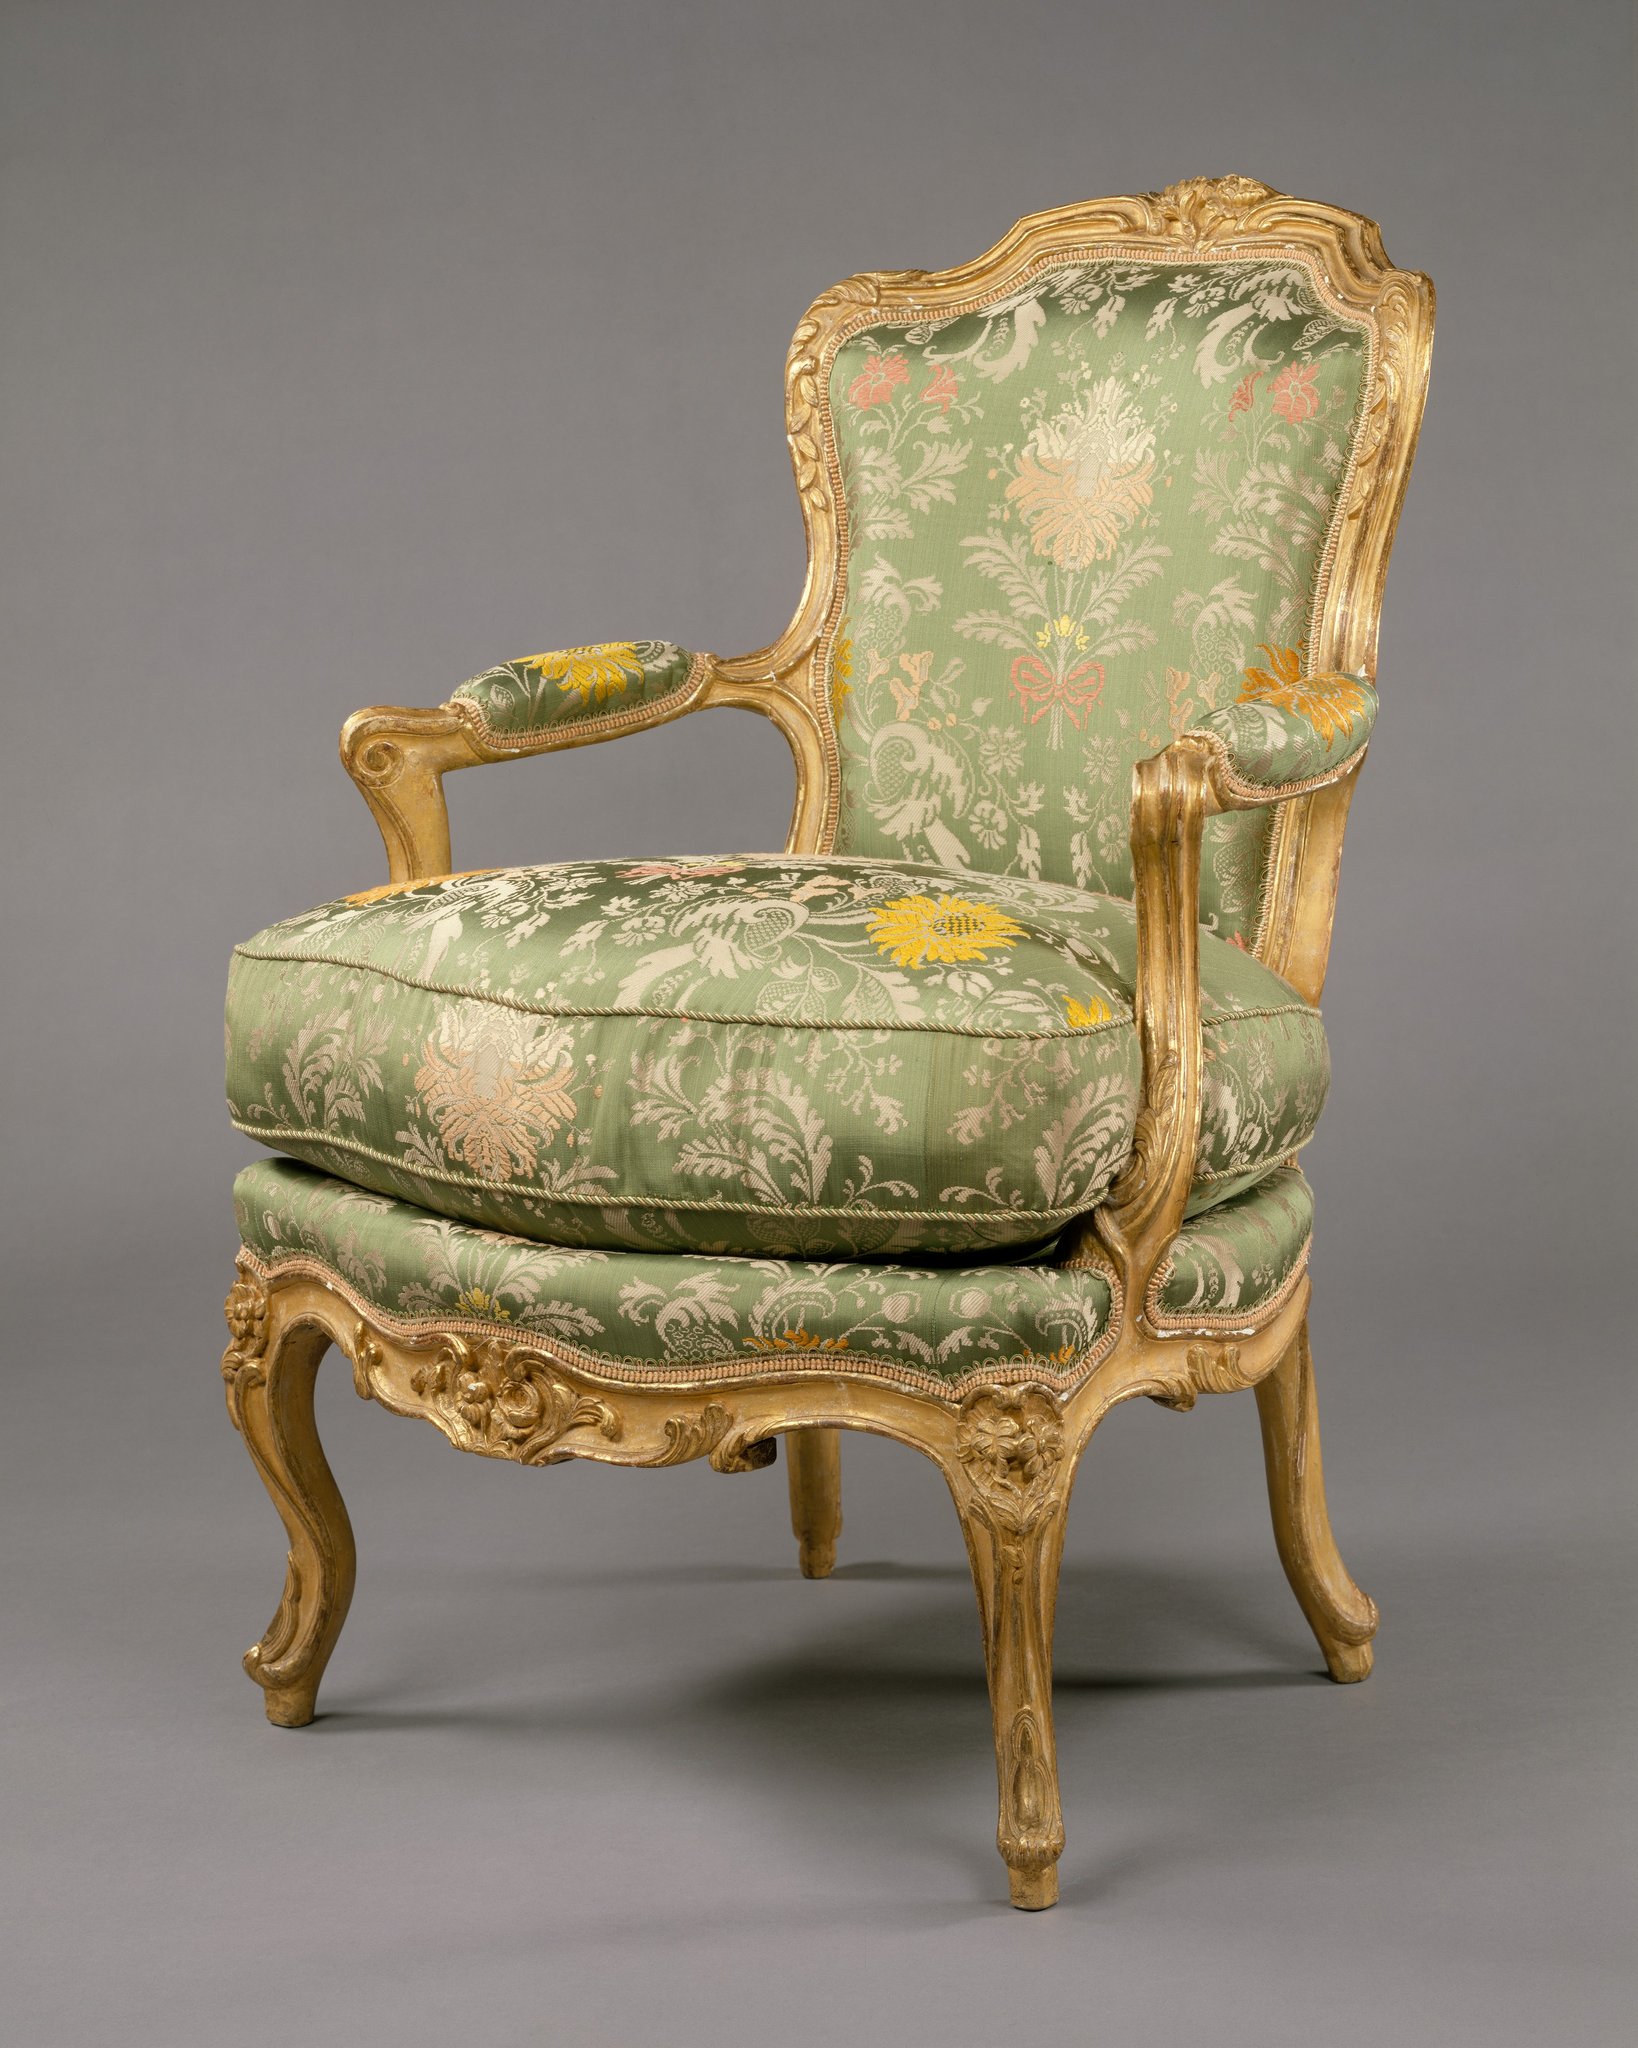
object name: armchair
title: Set of four armchairs (fauteuils en cabriolet)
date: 1750-1760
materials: wood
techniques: carving, gilding